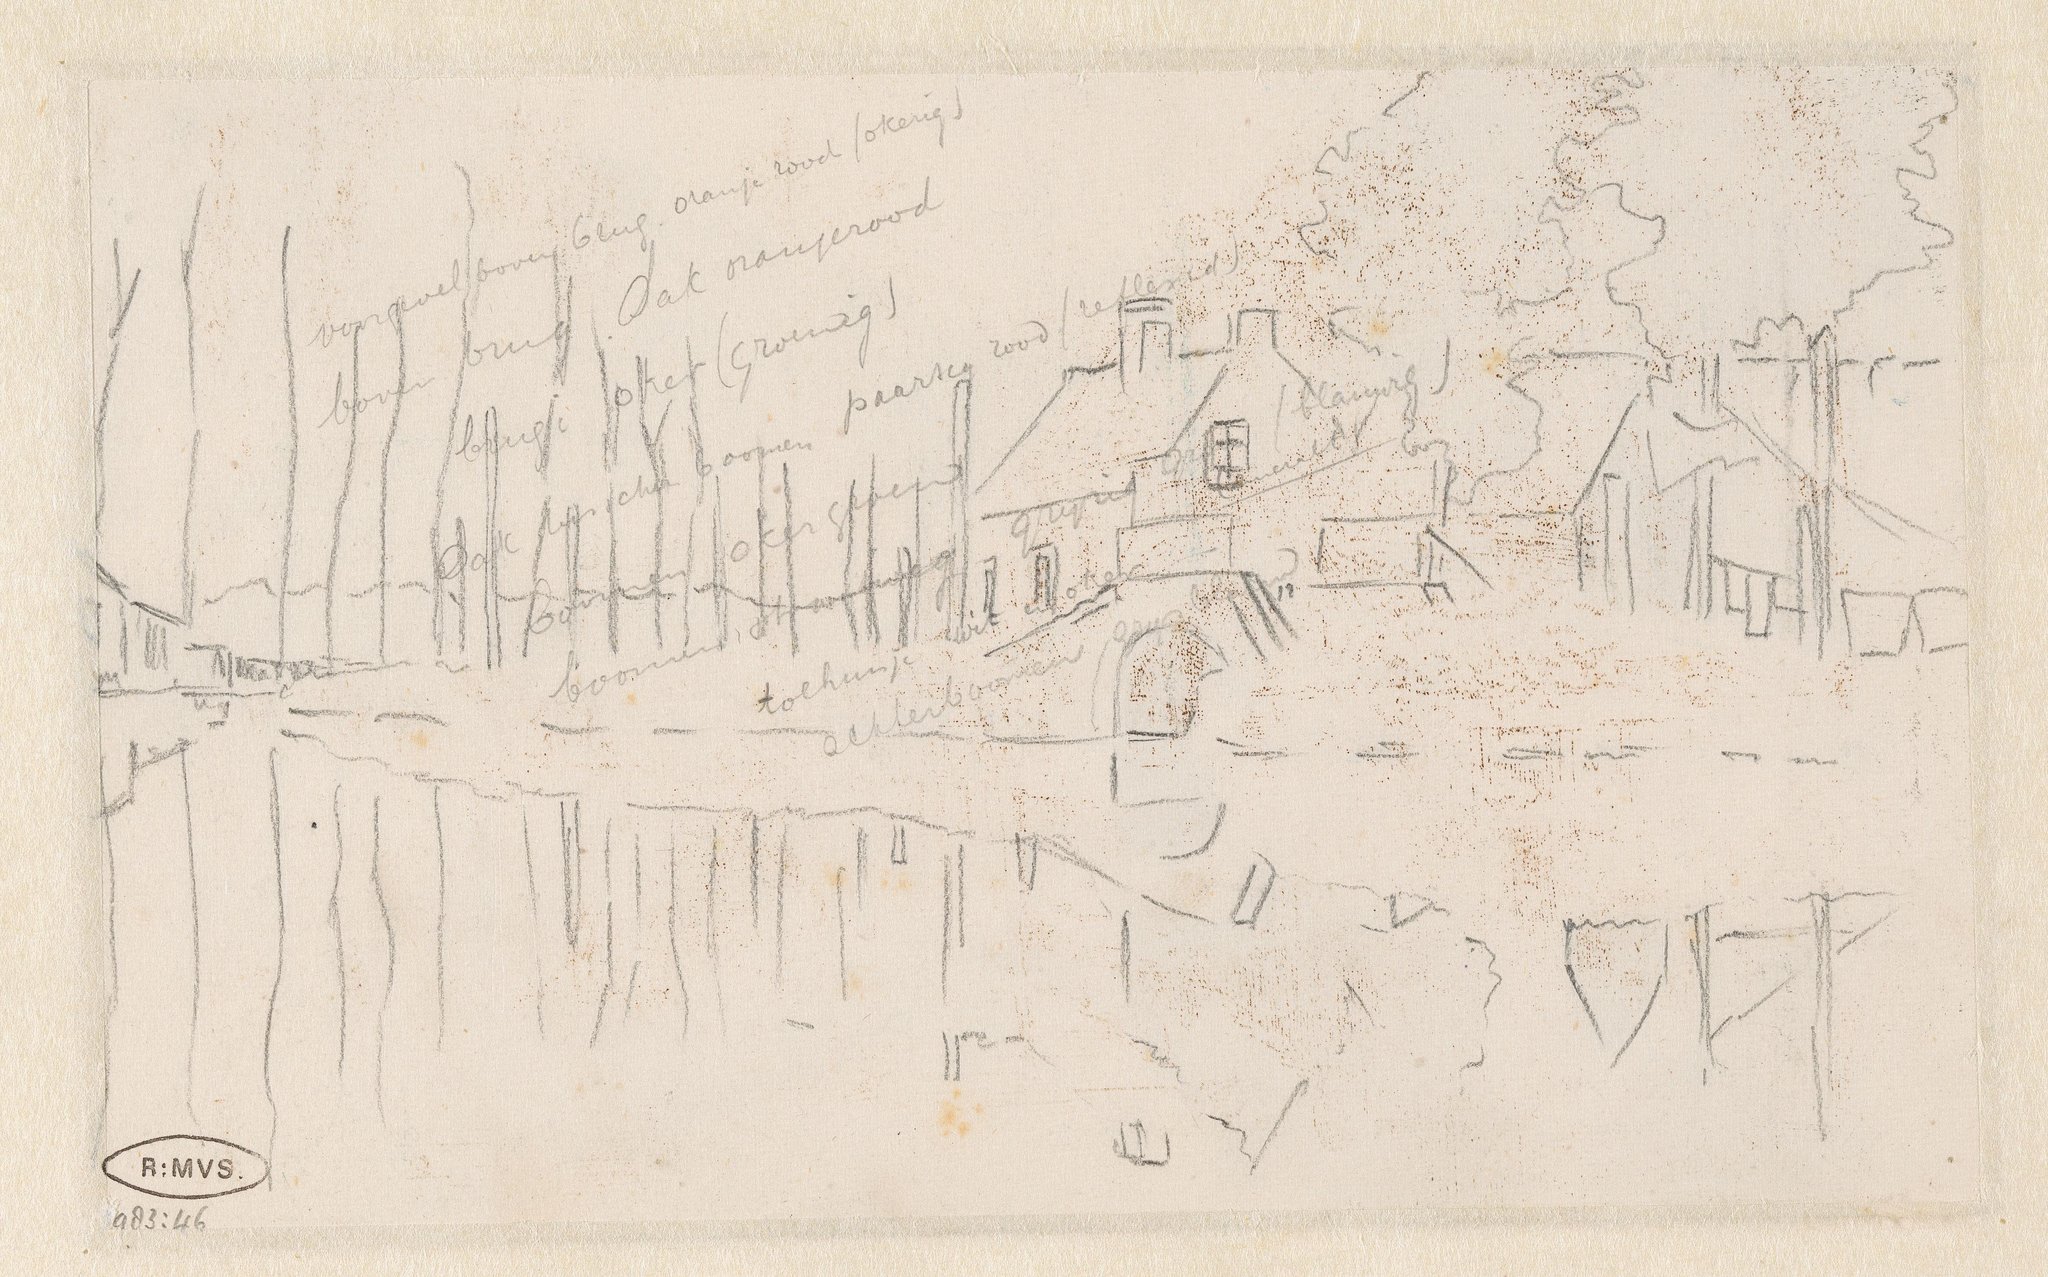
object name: drawing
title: Bruggetje over de Vecht bij Maarssen (voorstelling doorgetrokken van de voorkant, met kleurnotities)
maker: otto verhagen (i)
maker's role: draughtsman, print maker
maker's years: 1885-1951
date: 1912-1951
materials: paper, pencil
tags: landscape with bridge, viaduct or aqueduct, maarssen, vecht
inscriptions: collector's mark: Lugt 2228